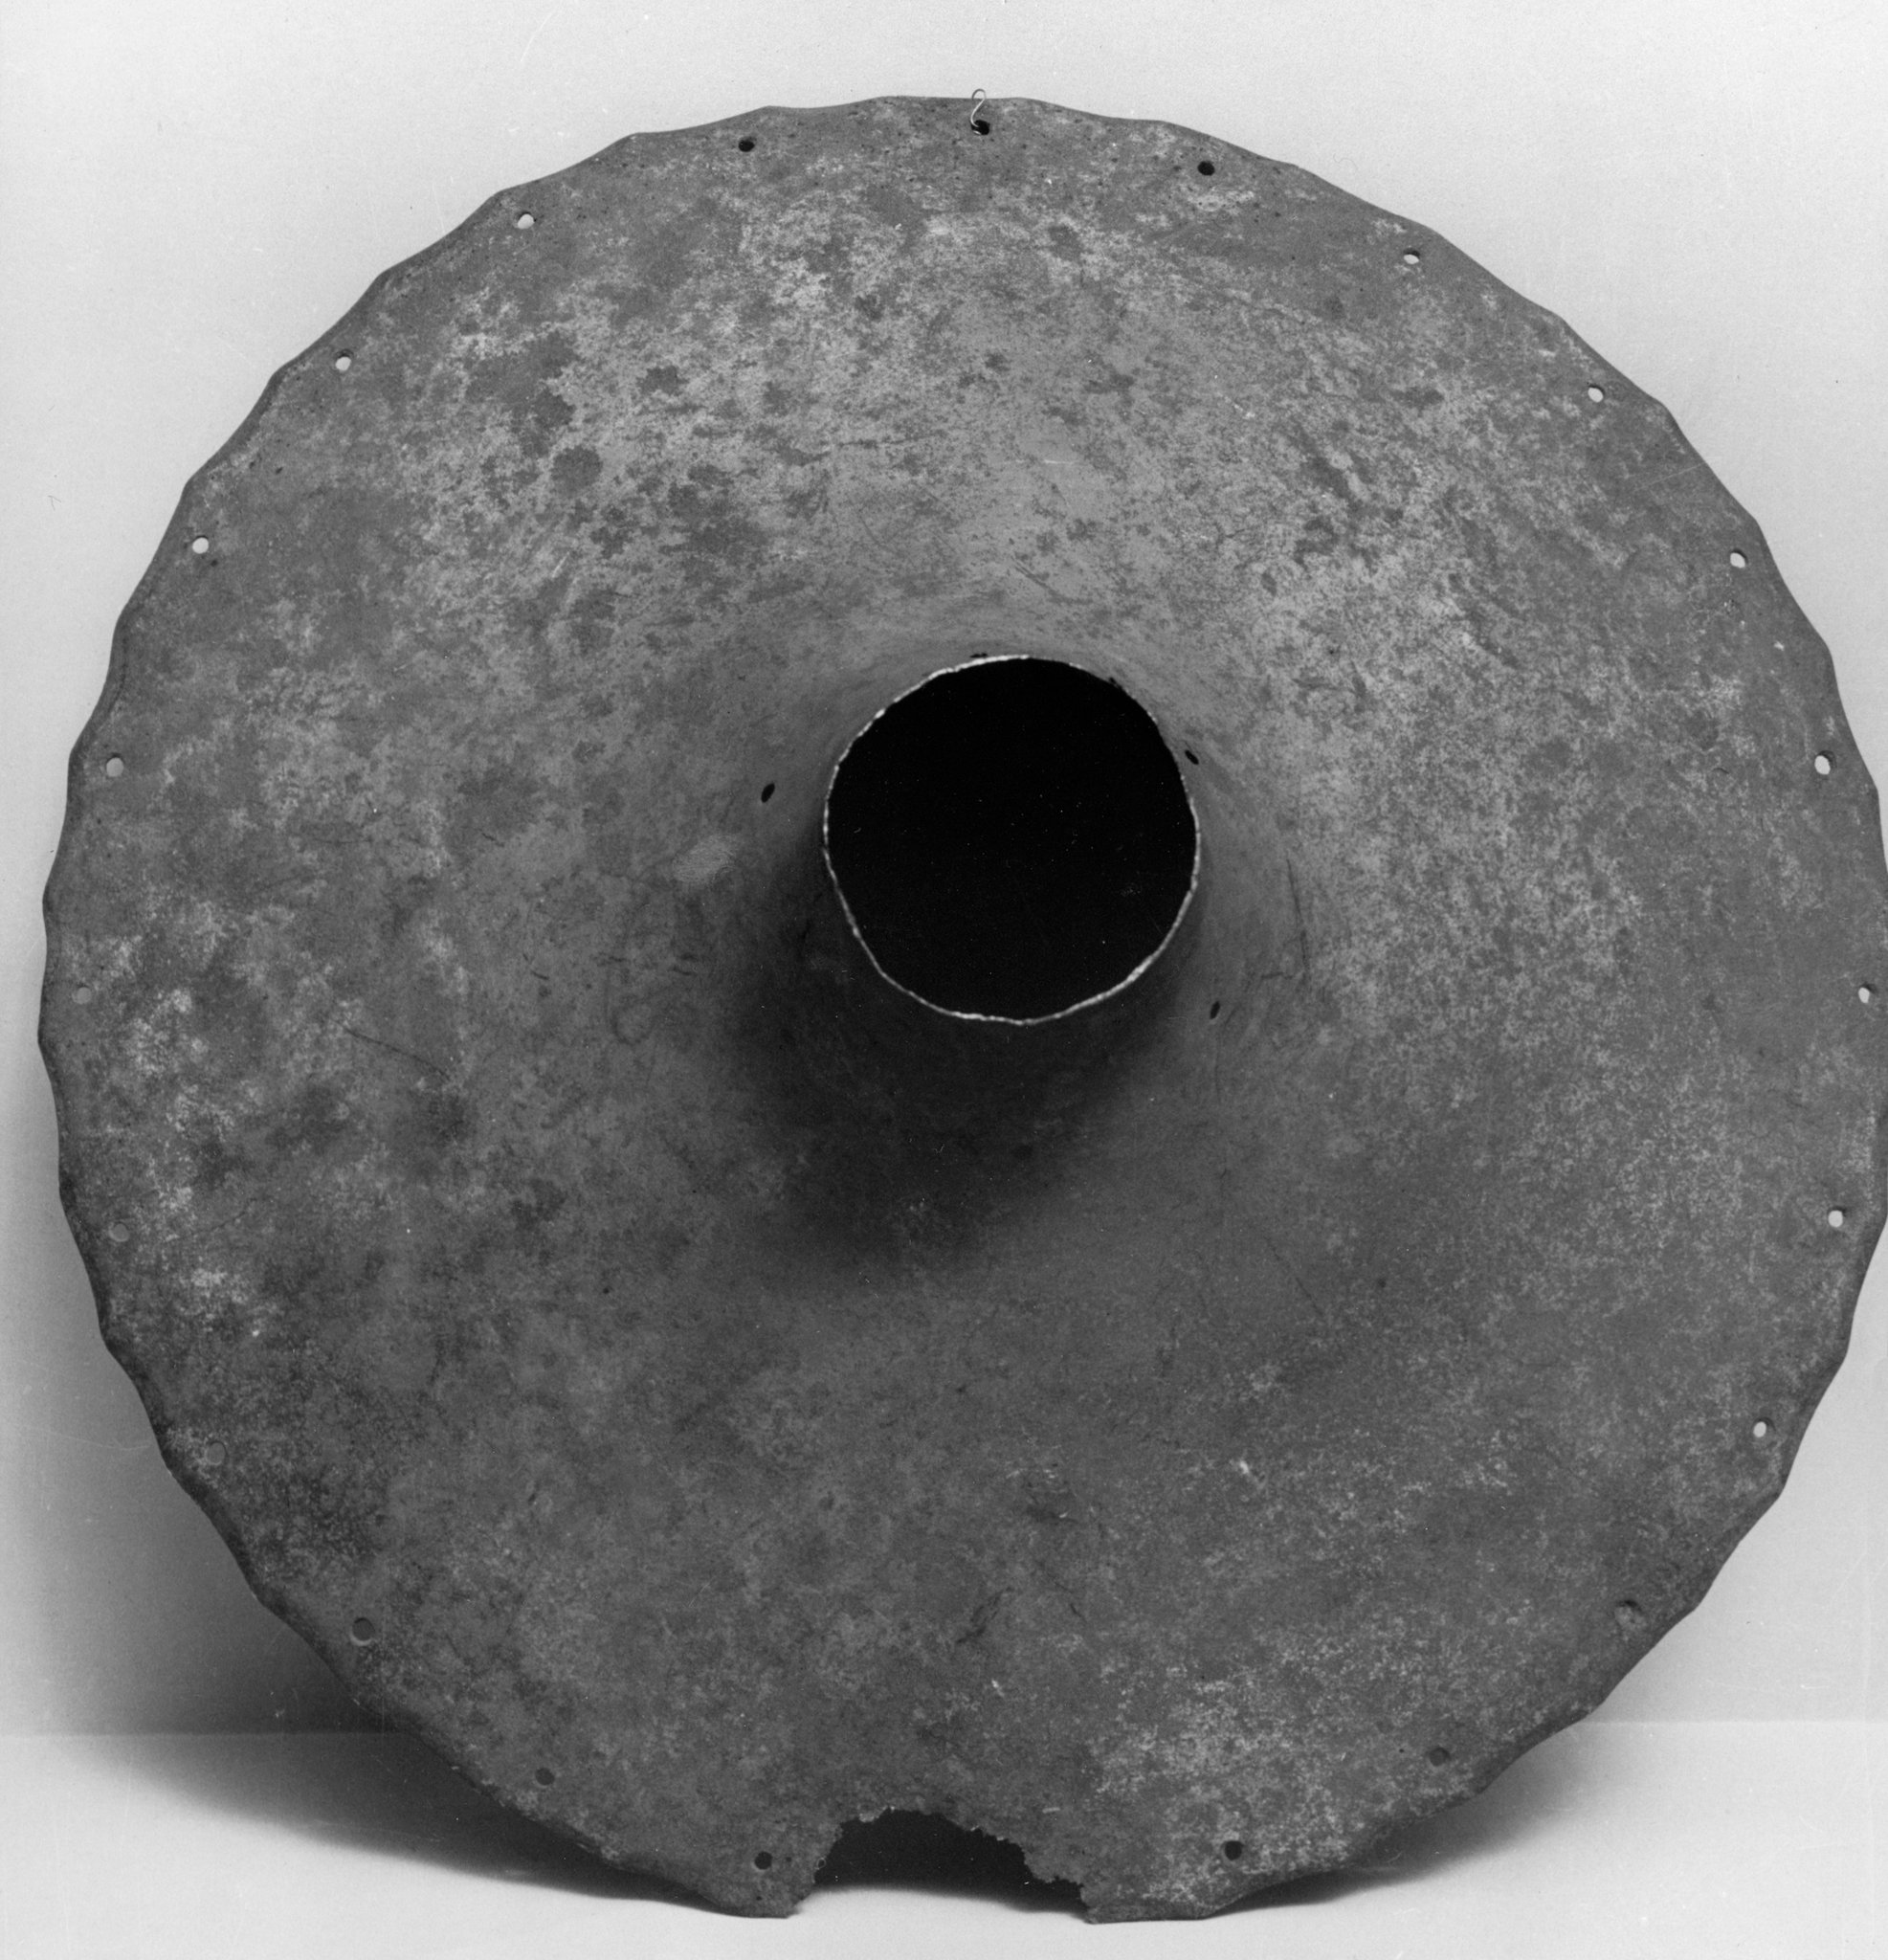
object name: vamplate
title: Vamplate of a Jousting Lance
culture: german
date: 1501-1600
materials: steel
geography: germany